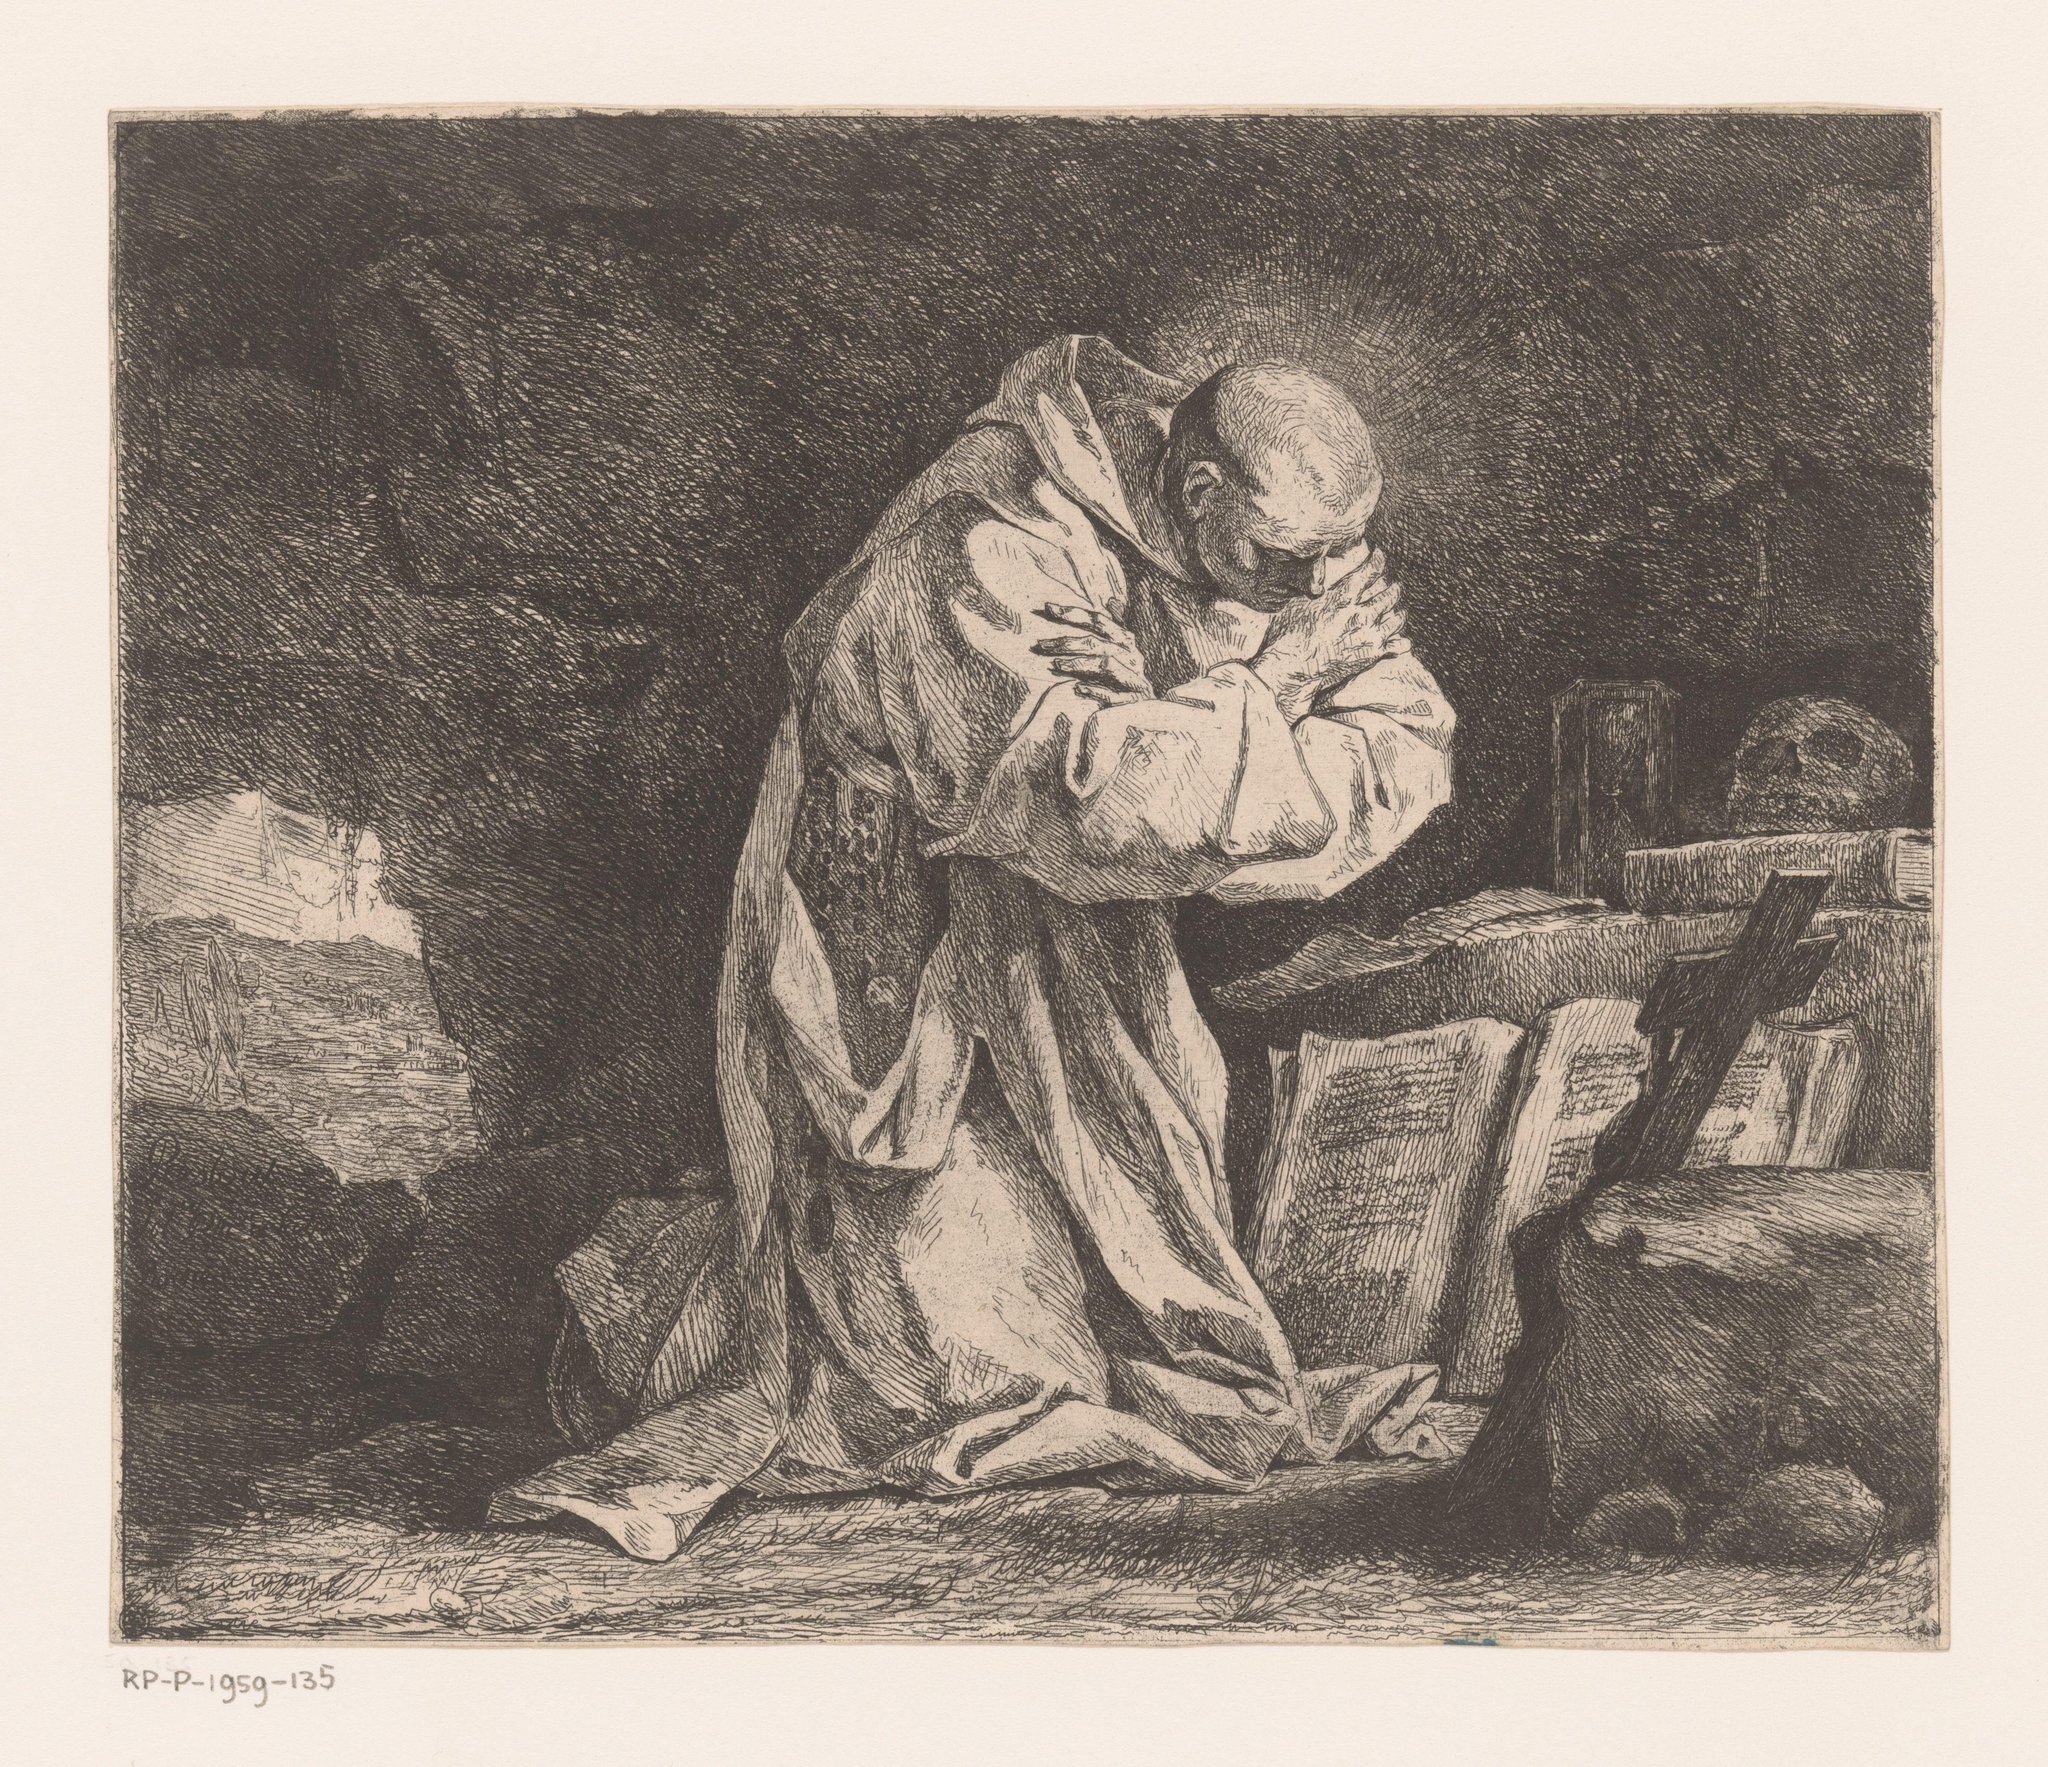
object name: print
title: Heilige Bruno geknield in gebed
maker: jean bernard restout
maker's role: print maker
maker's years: 1732-1797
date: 1764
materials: paper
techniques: etching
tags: the founder of the order of the carthusians, bruno; possible attributes: cross, finger at lips, lily, mitre at his feet, olive-branch, ray of light, skull, (seven) star(s)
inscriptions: collector's mark: Lugt 2228, collector's mark: Lugt 2760